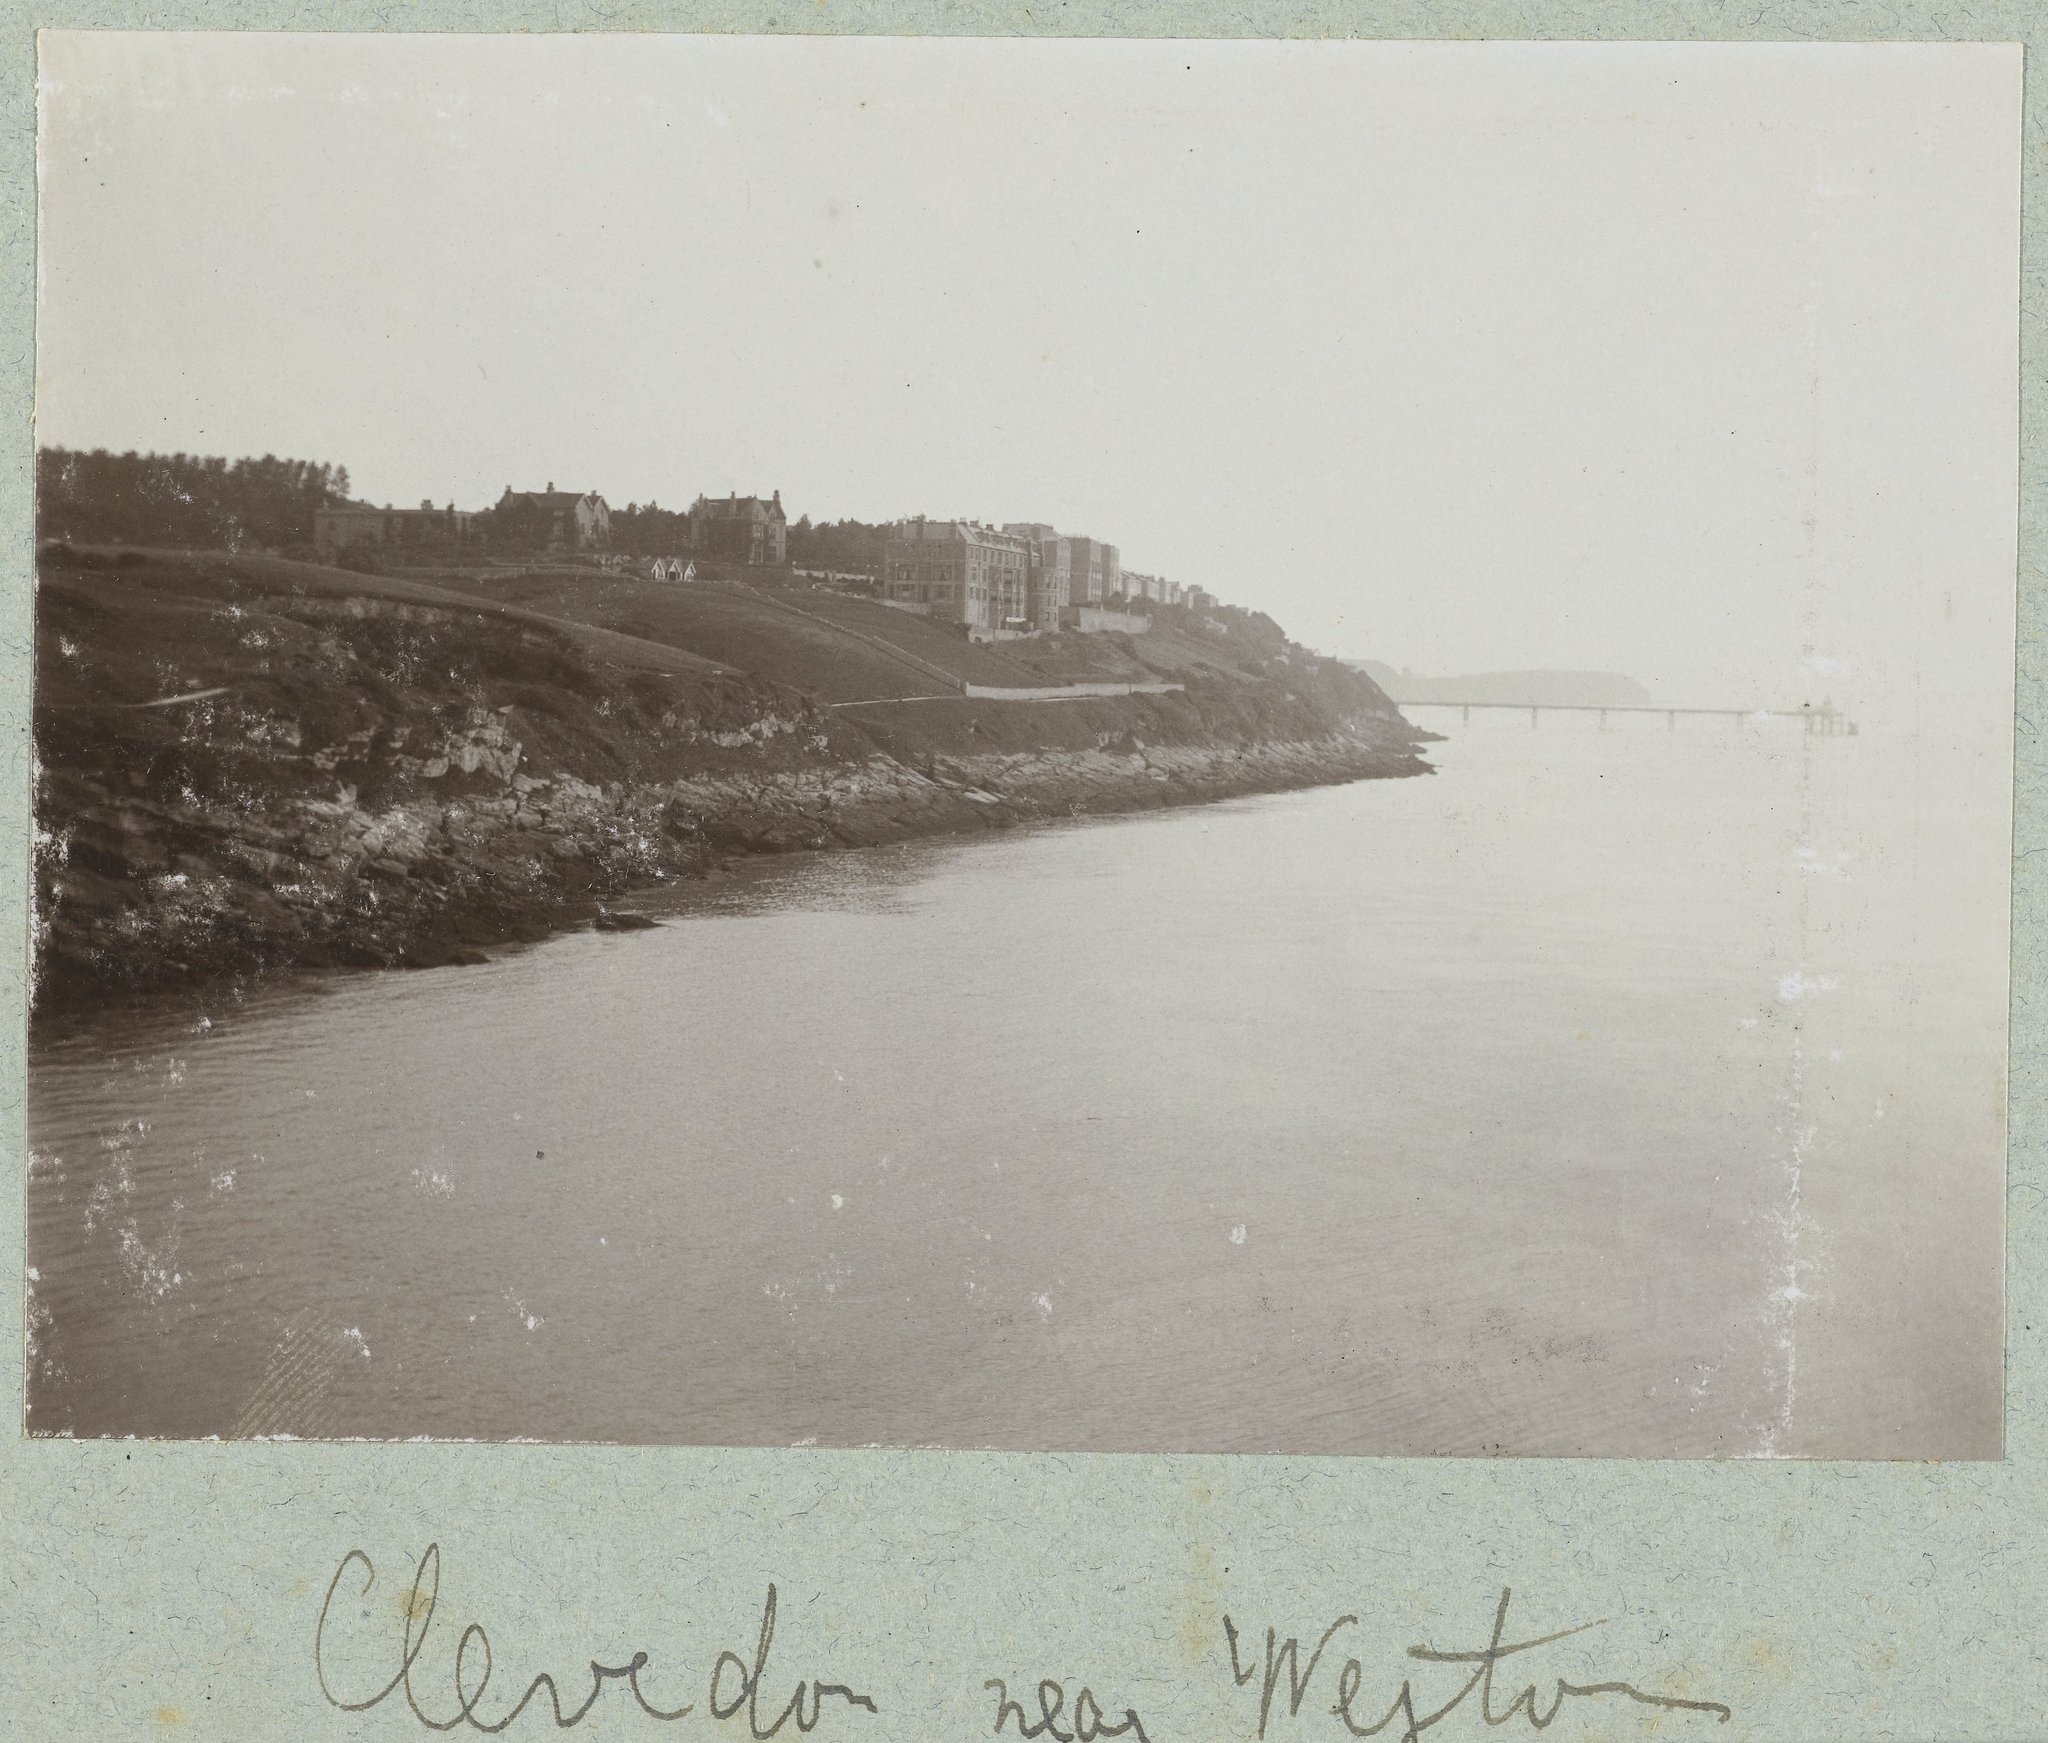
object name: photograph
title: Stadsgezicht vanaf zee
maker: frits freerks fontein fz.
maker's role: fotograaf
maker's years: 1882-1928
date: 1901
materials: cardboard, paper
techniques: gelatin silver print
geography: england